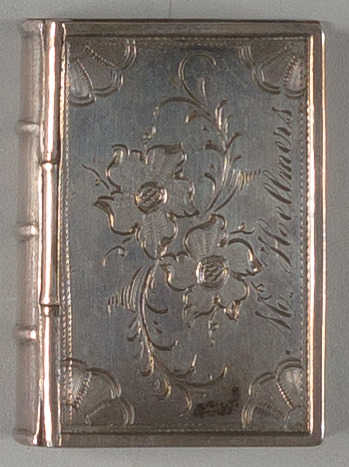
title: Hinged box, M. Hellmers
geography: europe